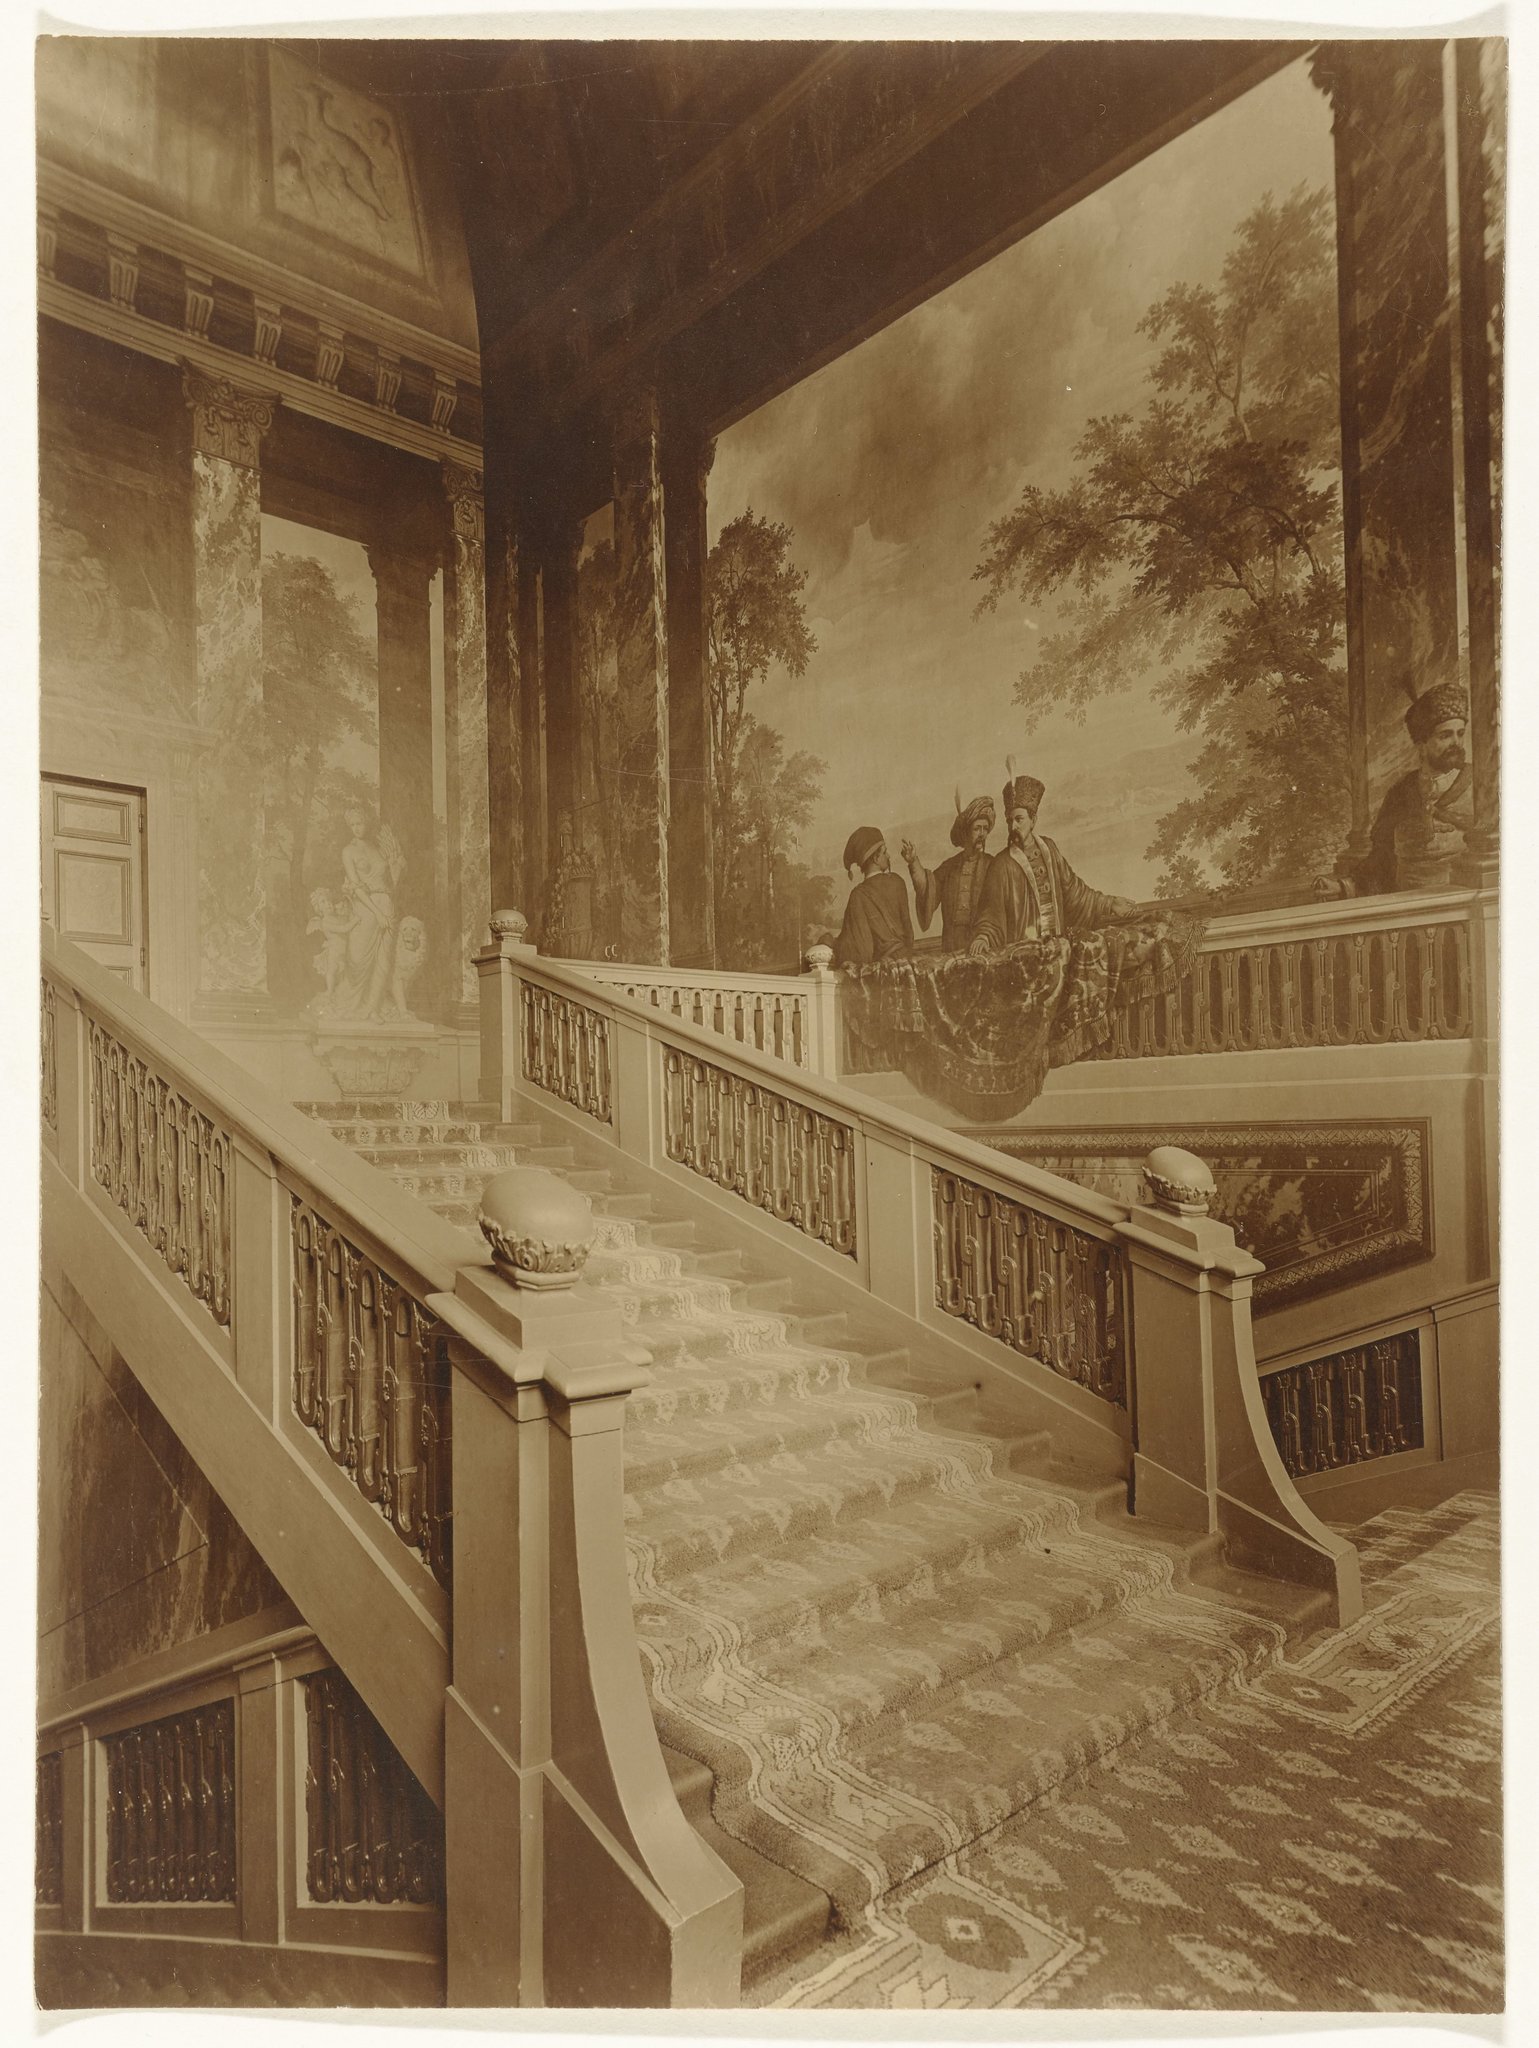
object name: photograph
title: Gezicht in het trappenhuis van Paleis Het Loo in Apeldoorn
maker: richard tepe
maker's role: fotograaf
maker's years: 1864-1952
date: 1900-1930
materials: paper, photographic support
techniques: gelatin silver print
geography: netherlands